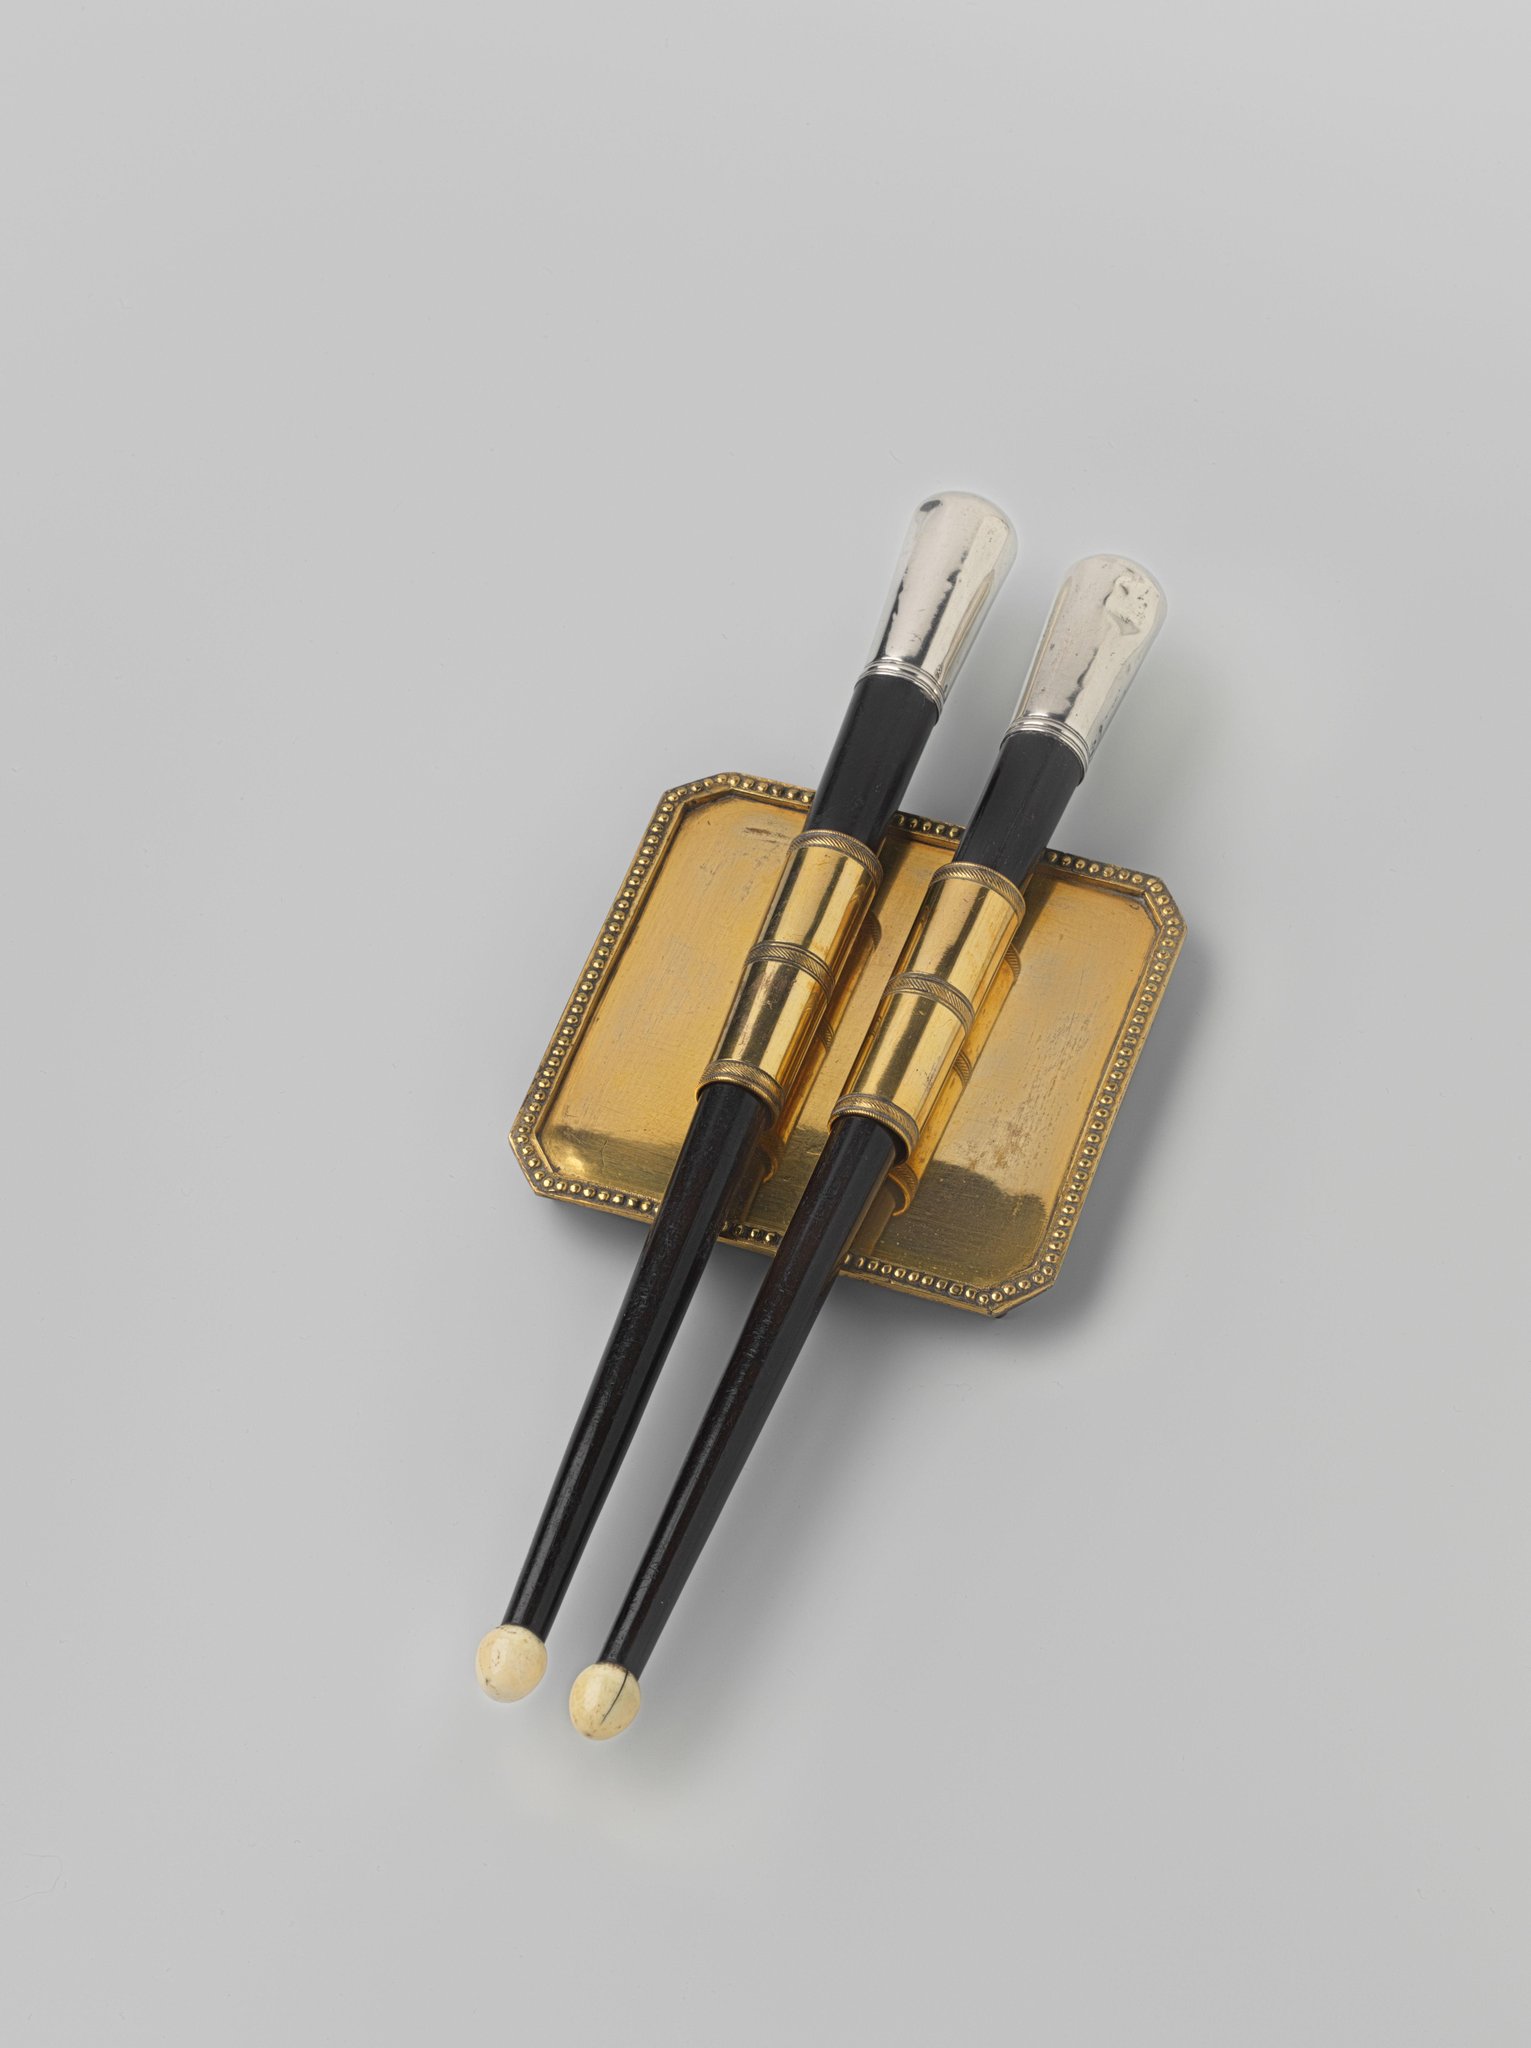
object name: drumstick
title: Drumsticks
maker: Anonymous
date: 1817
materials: wood, ivory, plate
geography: netherlands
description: Ebbenhouten tromstok voor tamboer-majoor met ivoren knop. Stokken bezet met bussen van pleet.